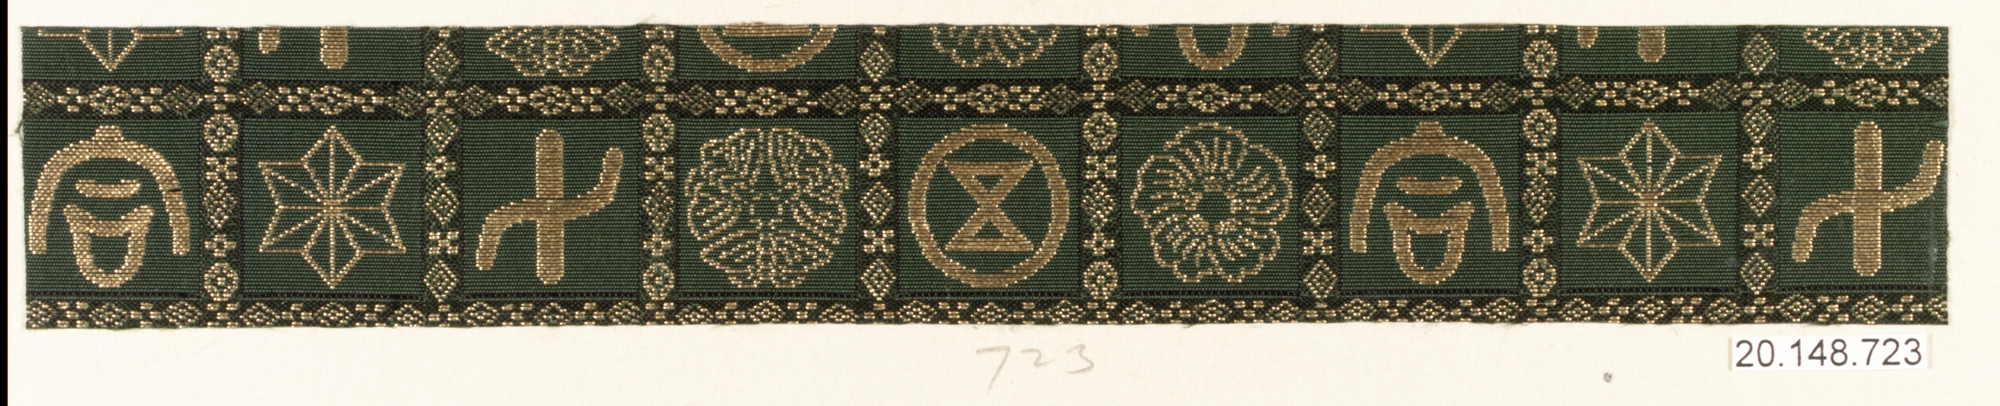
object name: piece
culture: japanese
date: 1701-1800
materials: silk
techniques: compound weave